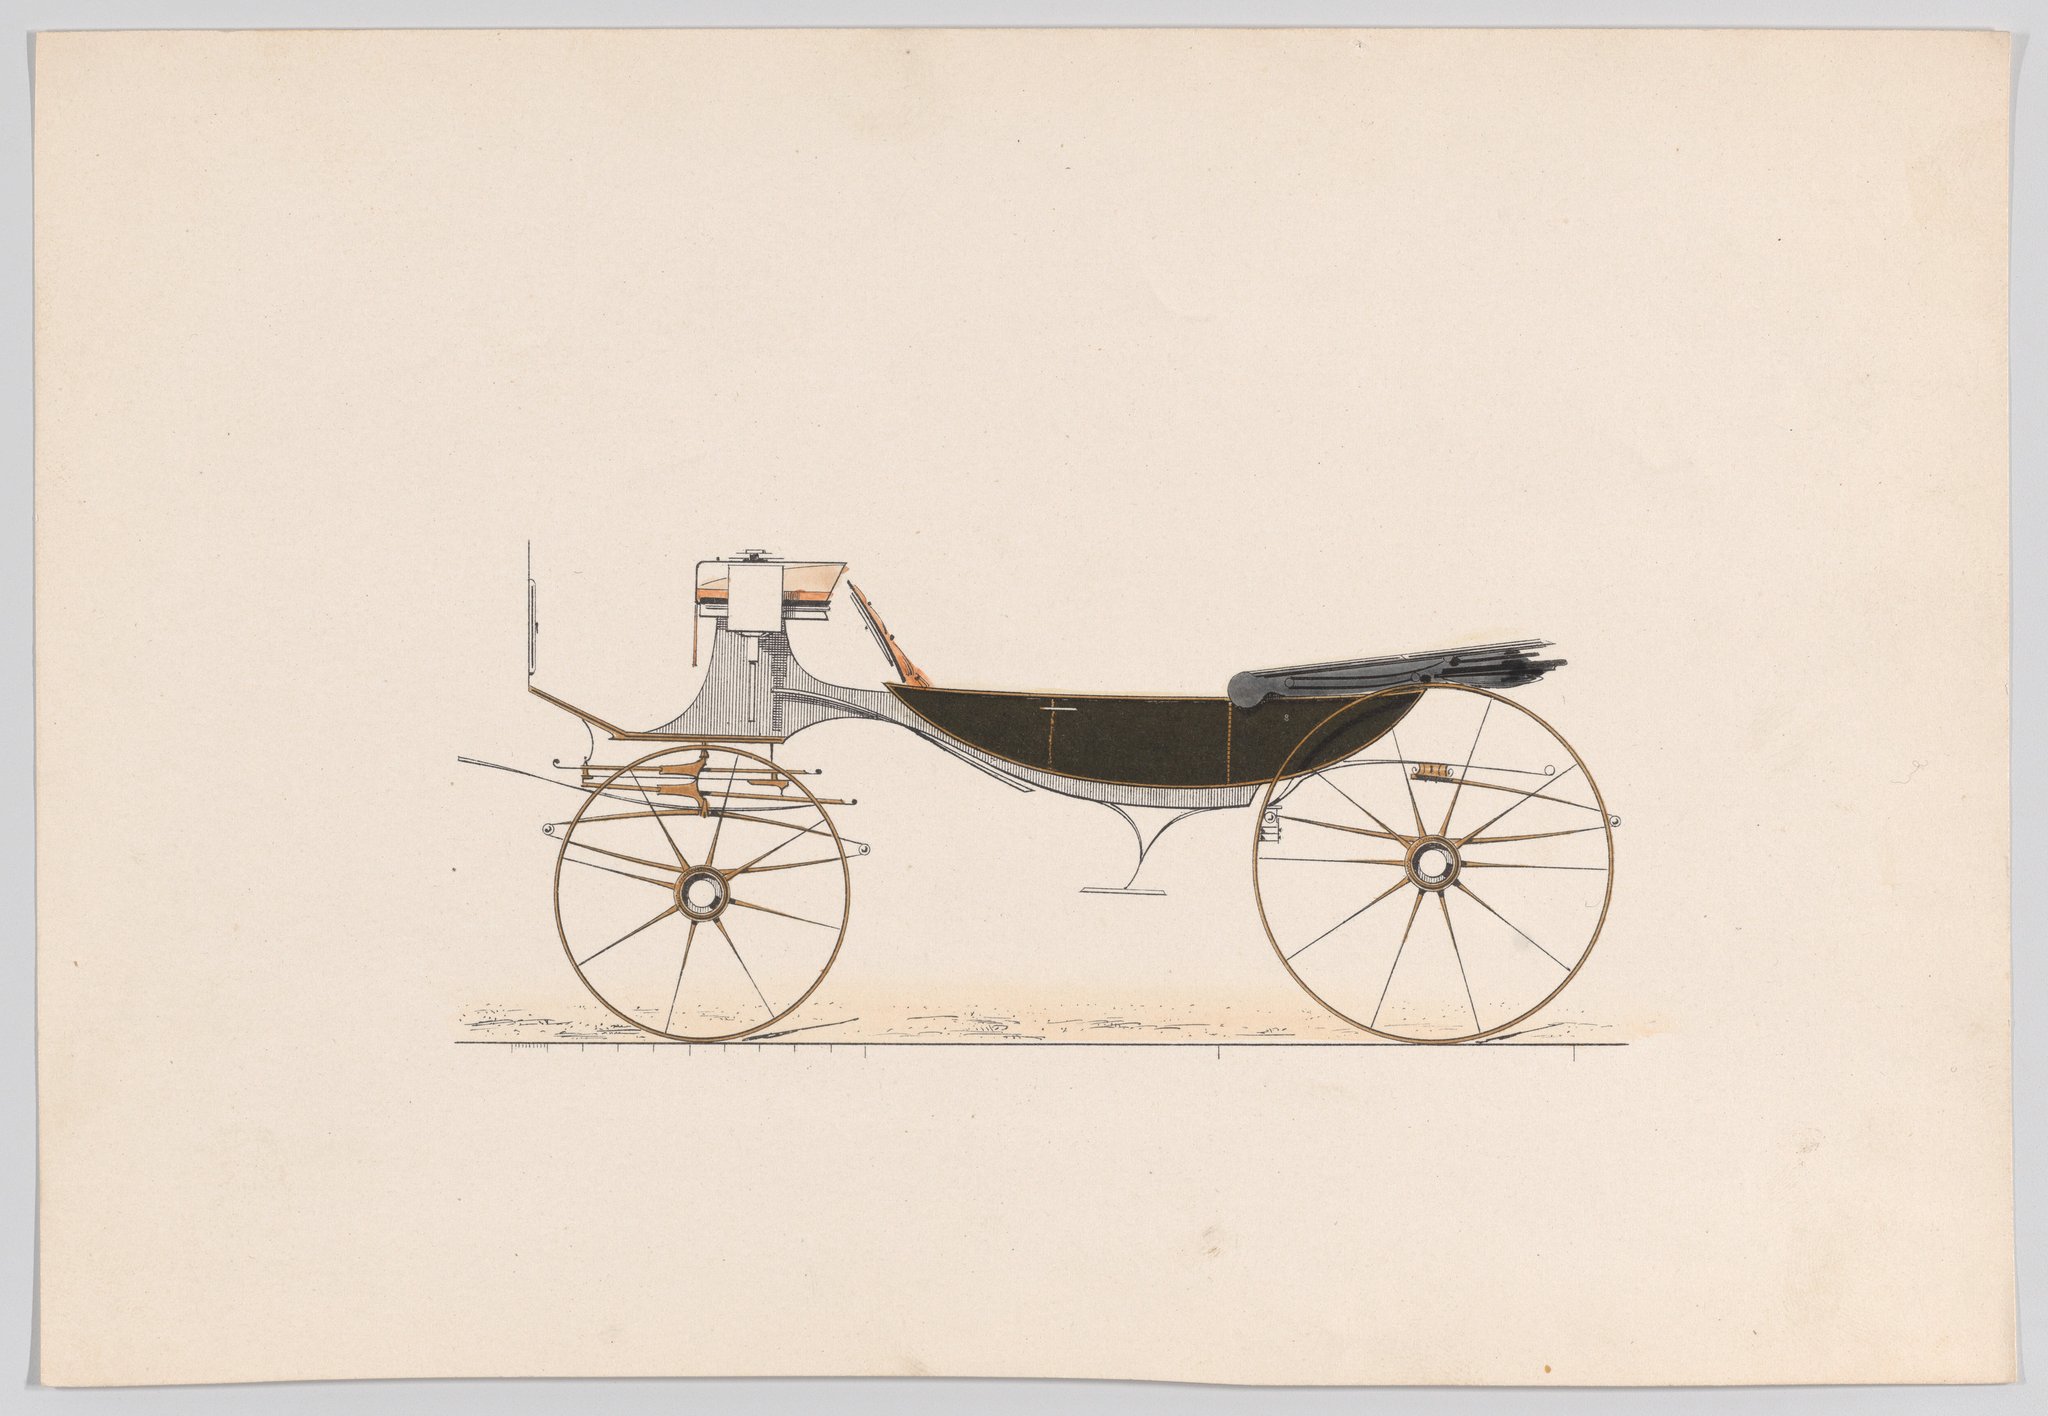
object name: print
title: Design for Vis-A-Vis Carriage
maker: anonymous, french, 19th century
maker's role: artist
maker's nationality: french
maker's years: 1800-1900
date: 1870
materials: gum arabic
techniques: hand coloring, lithograph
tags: carriages